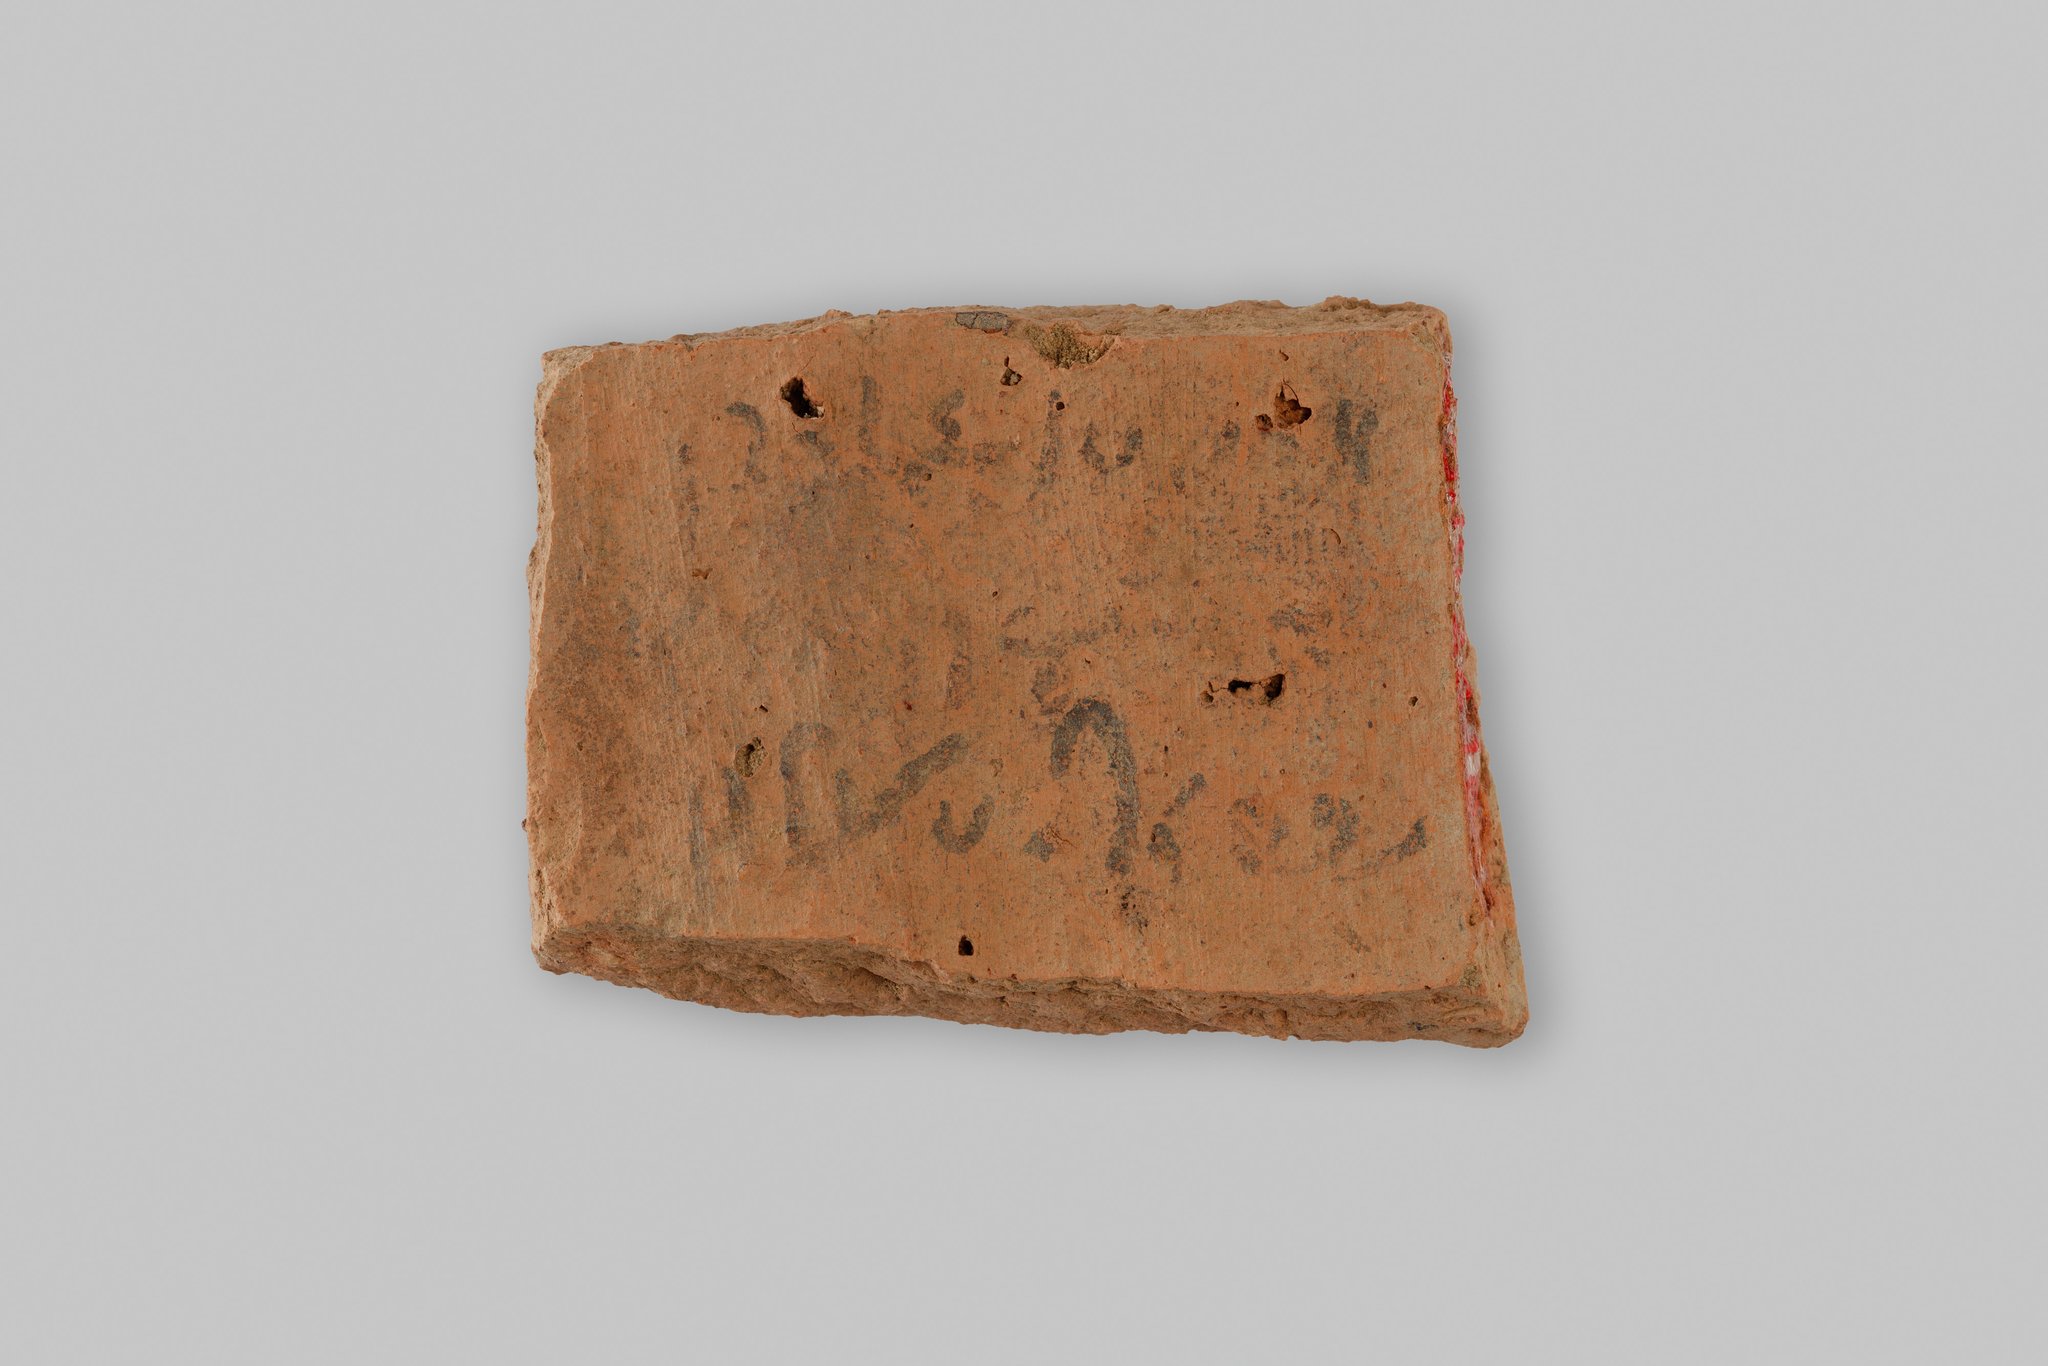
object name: ostracon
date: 400-30 BCE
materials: ink, pottery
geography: egypt